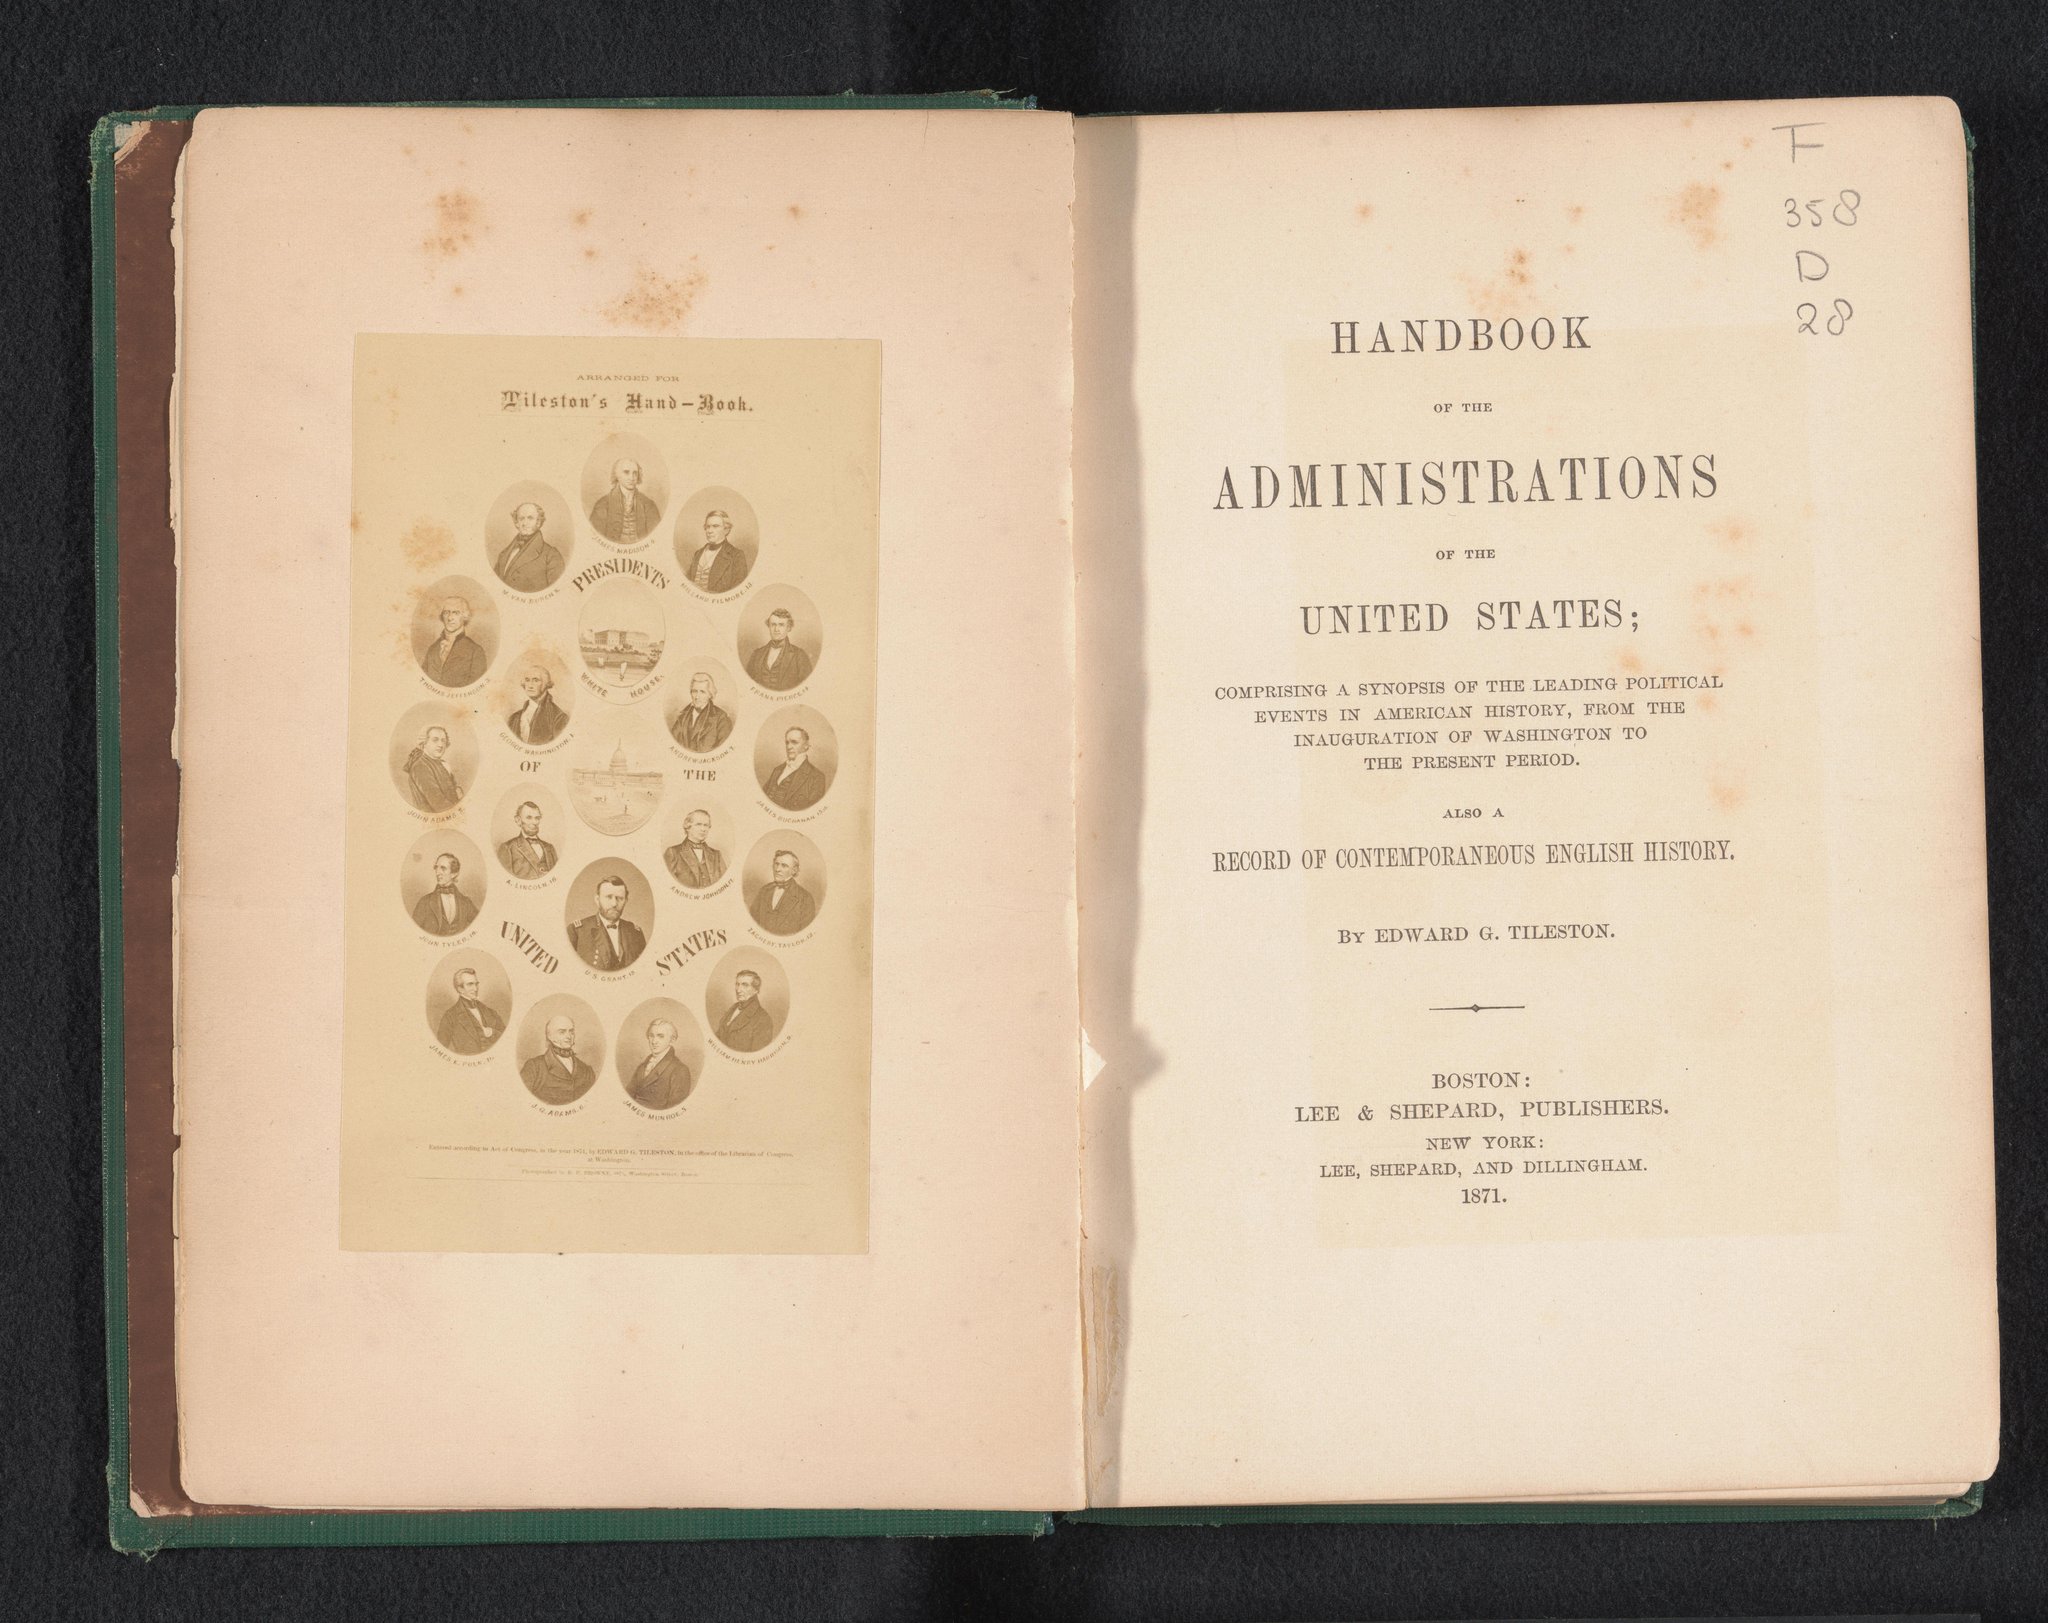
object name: photograph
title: Fotoreproductie van een pagina met achttien portretten van presidenten van de Verenigde Staten van Amerika en een gezicht op het Witte Huis en het Capitool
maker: b.p. browne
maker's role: fotograaf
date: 1866-1871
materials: photographic support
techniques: albumen print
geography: boston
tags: president ~ head of republic, façade (of house or building)